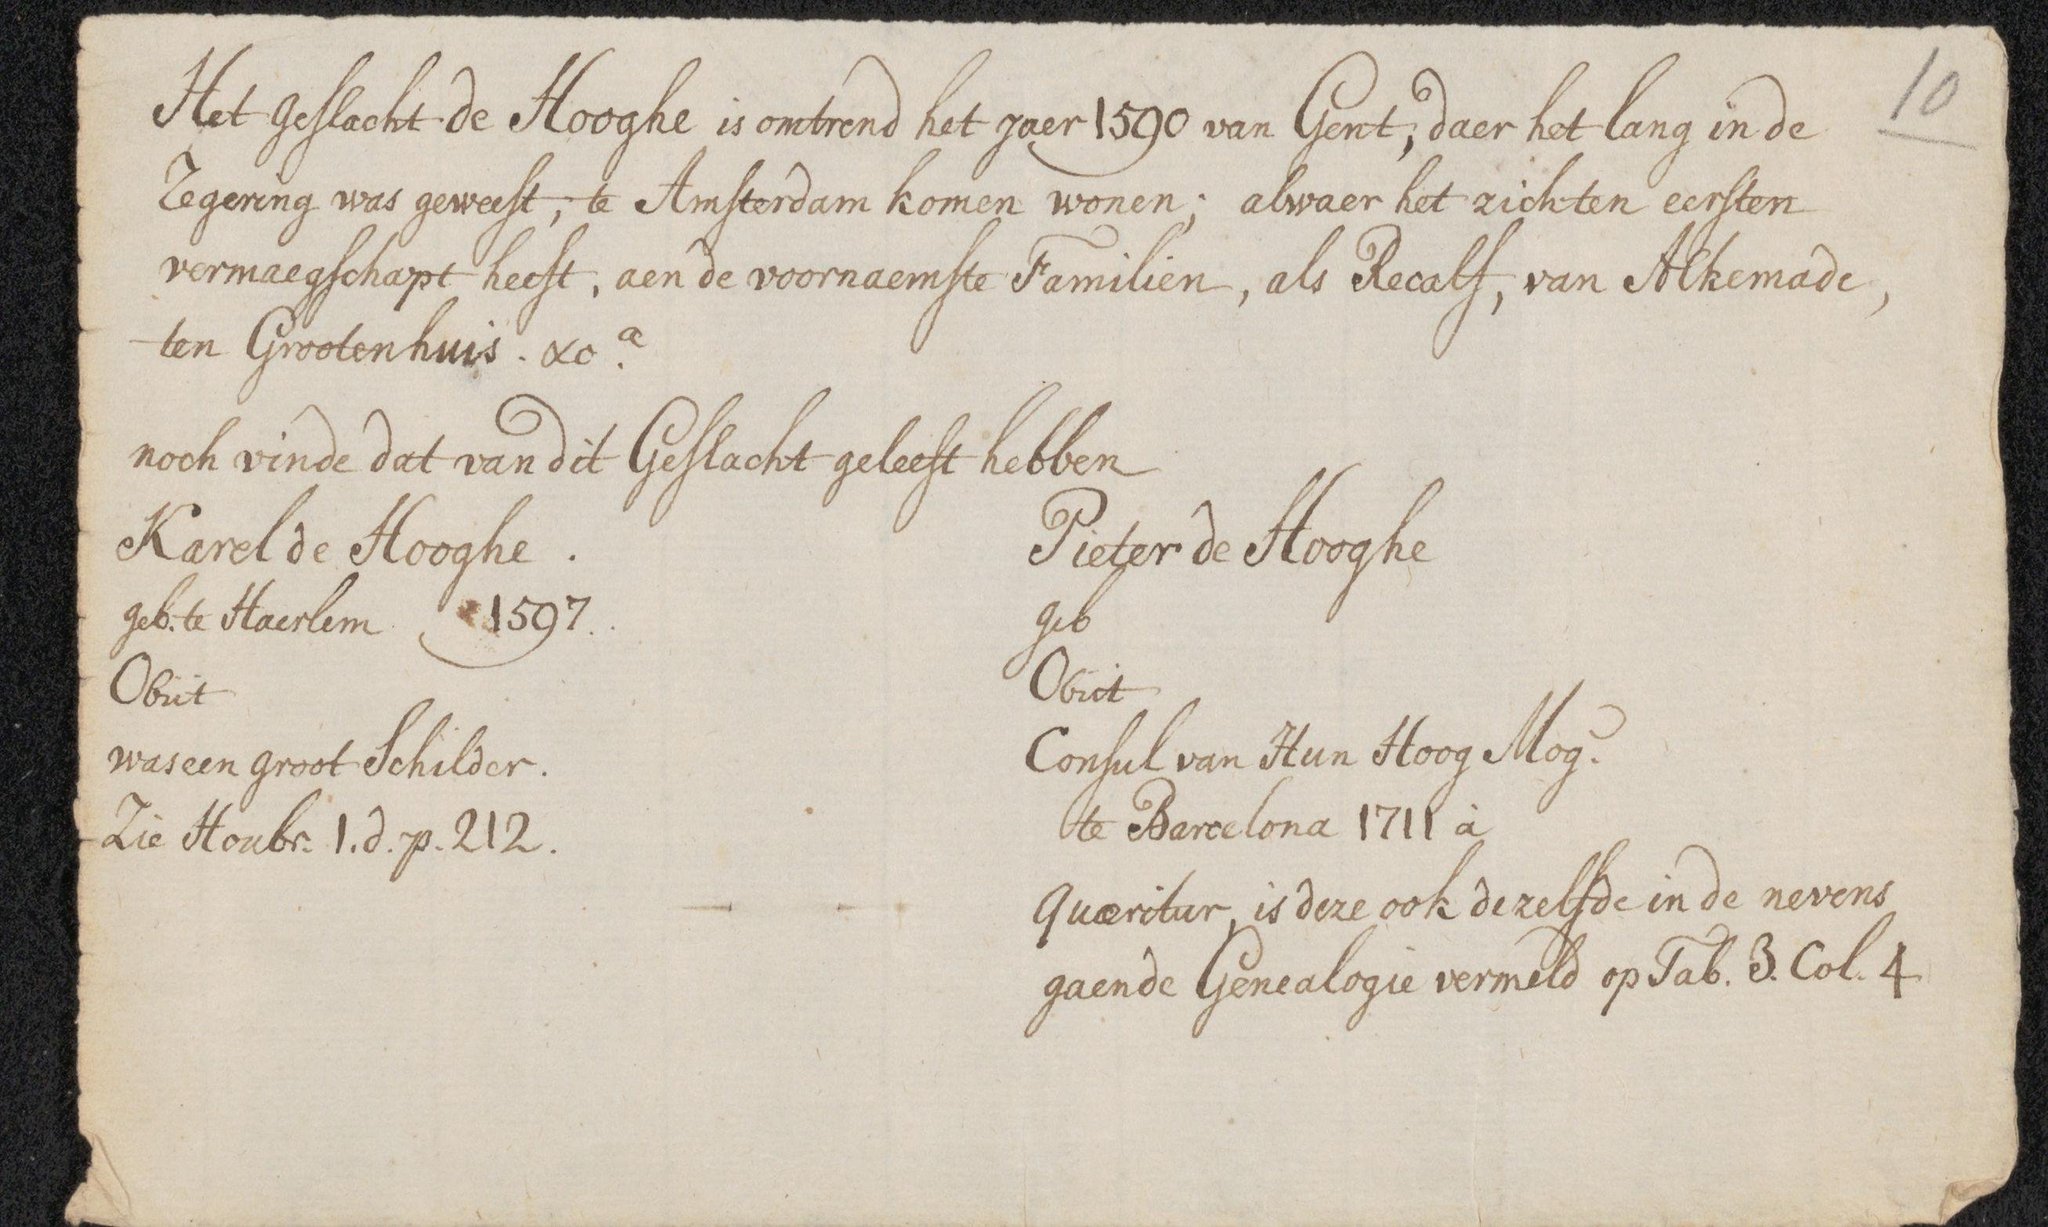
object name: manuscript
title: Handschrift betreffende de familie De Hooghe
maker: Anonymous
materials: ink, paper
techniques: pen, writing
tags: haarlem, painter, print maker, draughtsman, goldsmith, romeyn de hooghe, painting (including book-illumination, miniature-painting), ghent, amsterdam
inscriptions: collector's mark: Lugt 2233, watermark